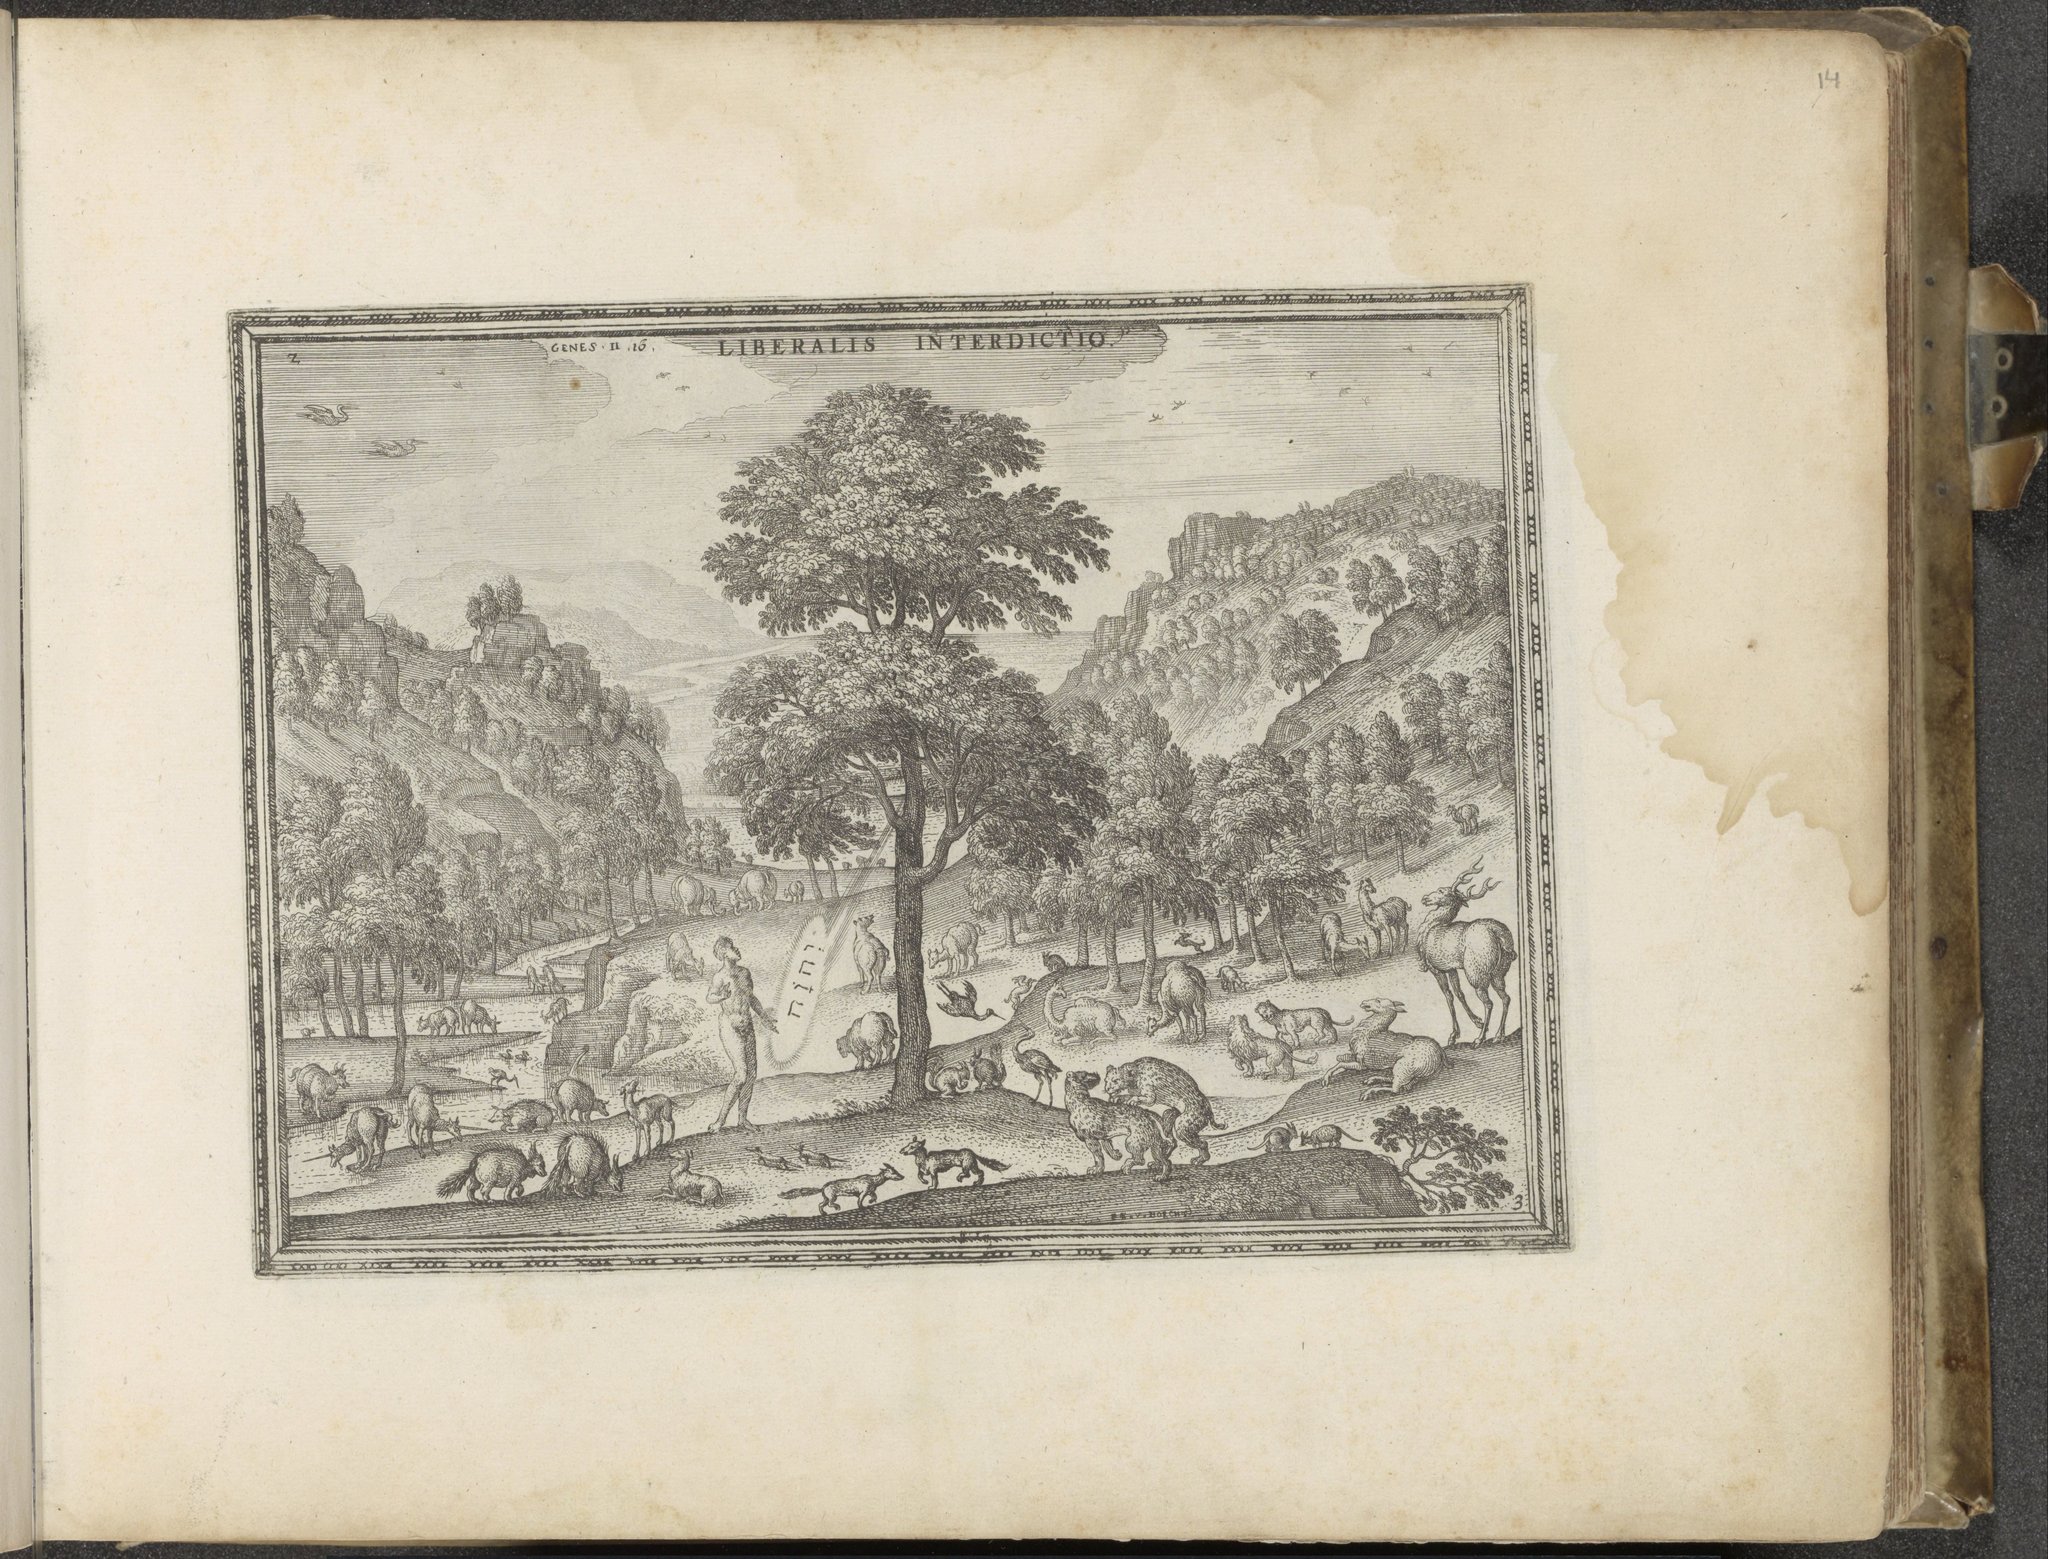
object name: album leaf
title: God toont Adam het paradijs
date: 1582-1593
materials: paper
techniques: etching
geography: amsterdam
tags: god brings adam to paradise, garden of eden, paradise, the tree of knowledge of good and evil (whose fruit, usually apples or figs, brings death); the tree may be guarded by the serpent, tetragram (in roman or hebrew script) ~ symbol of god the father, old testament, creation of the animals ~ genesis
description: God toont Adam het paradijs en de boom der kennis van goed en kwaad (Gen. 2:16). Aan de hemel het tetragram als symbool van God de Vader. De prent maakt deel uit van een album.